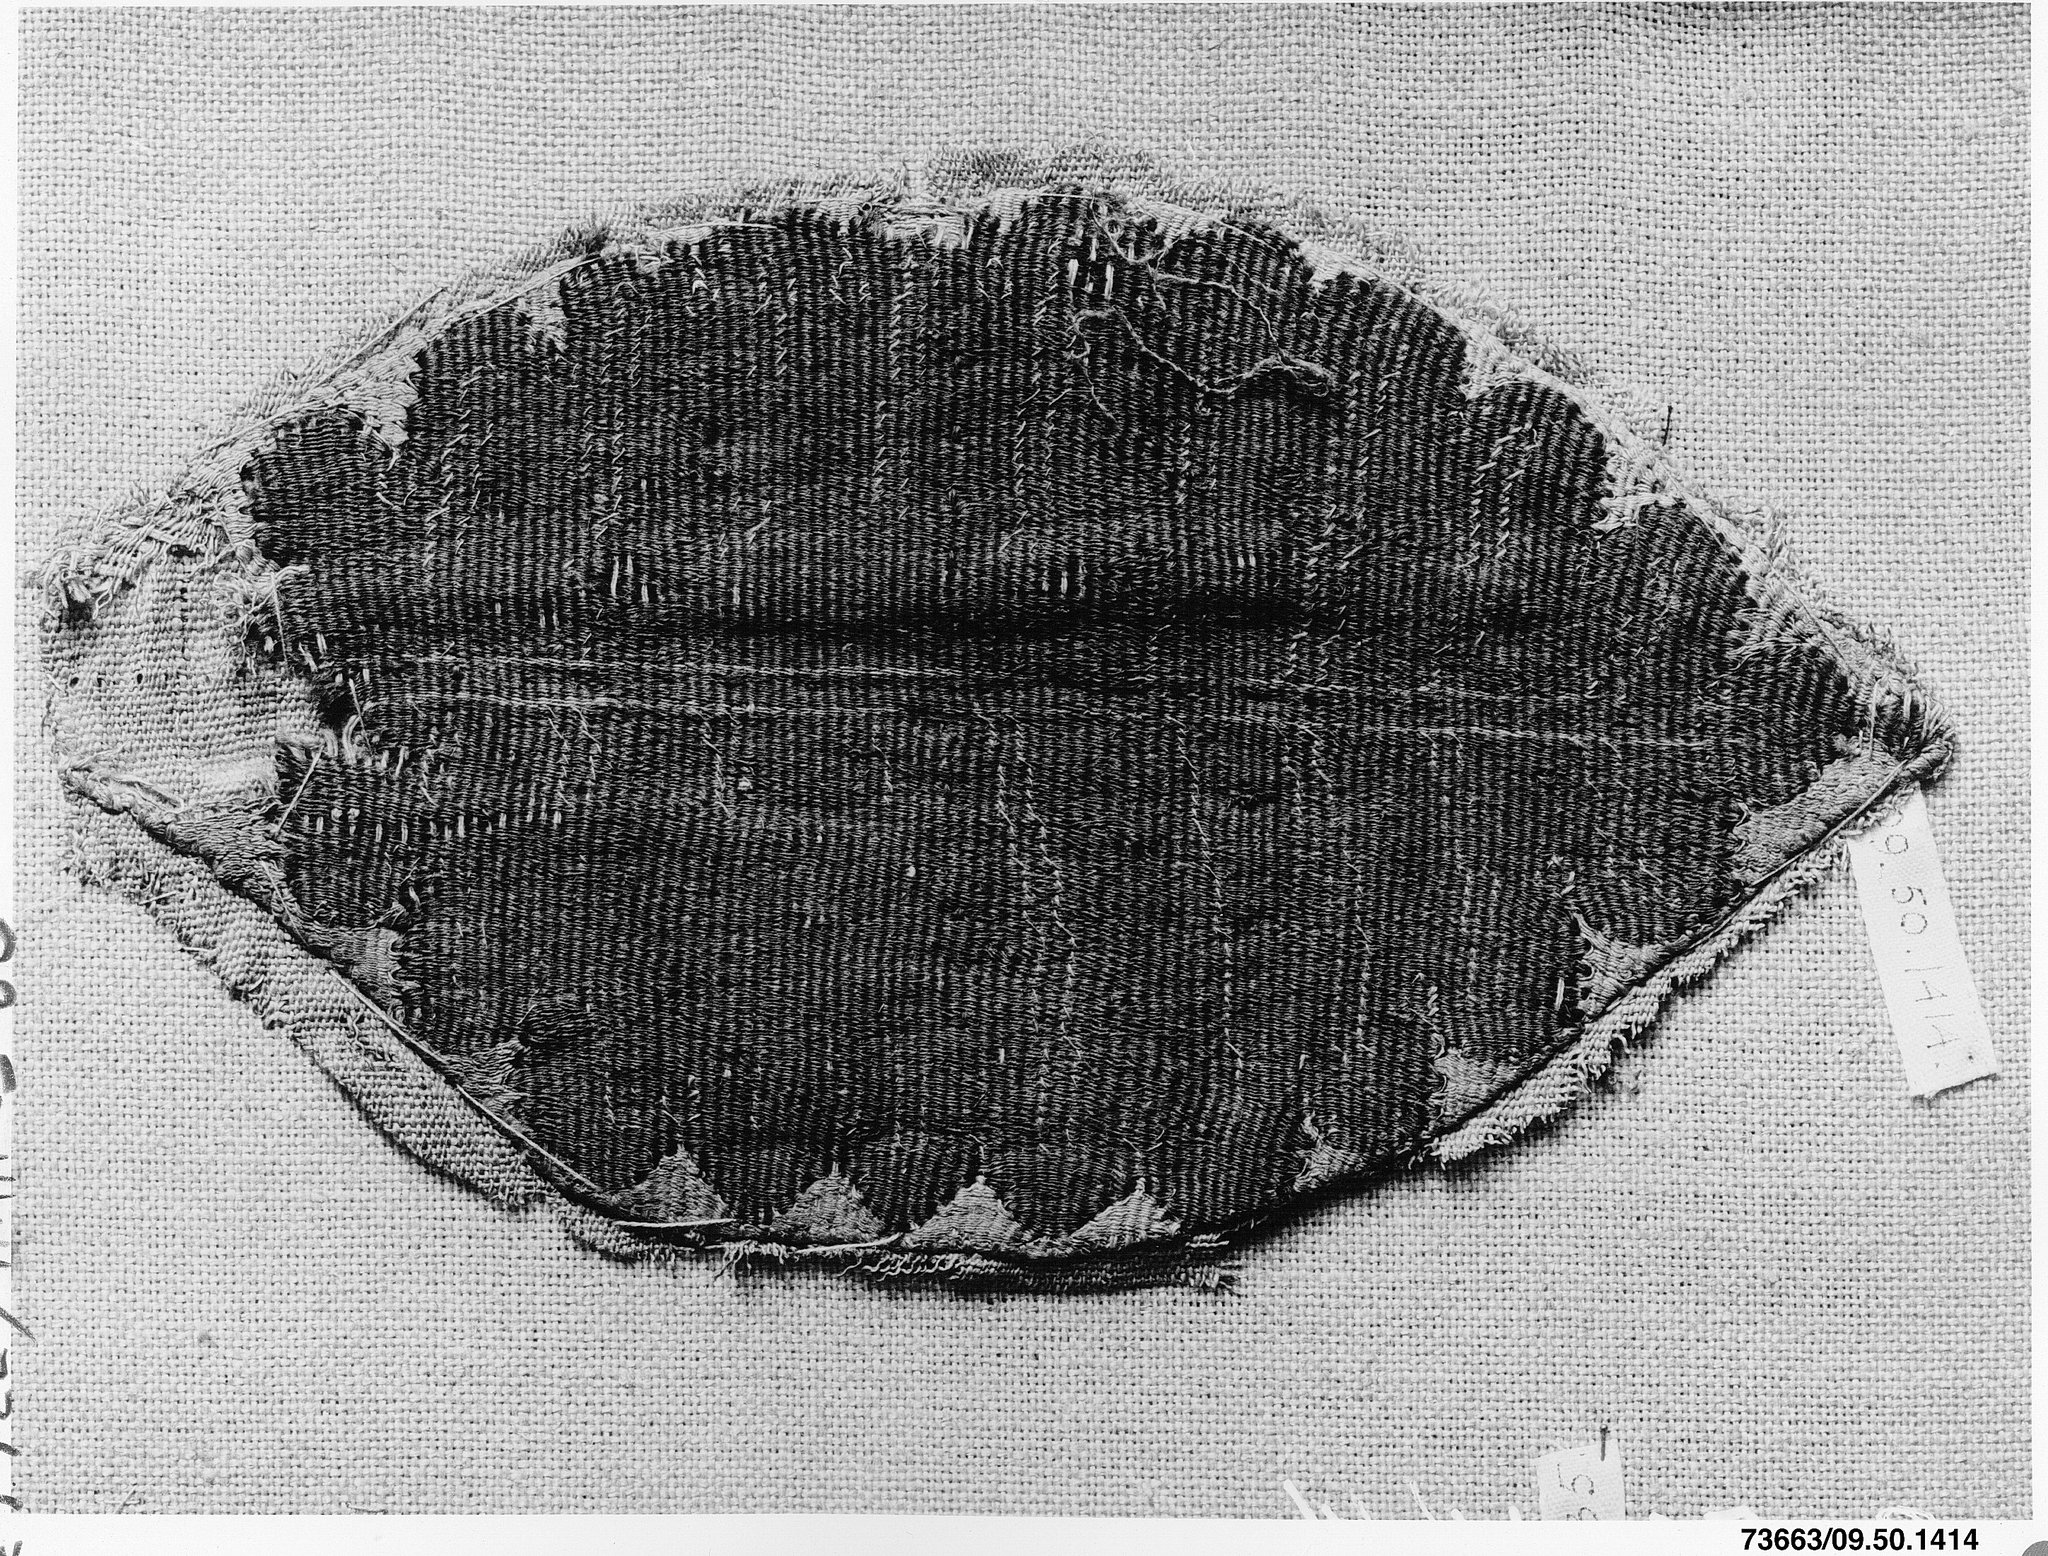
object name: textile fragment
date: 301-500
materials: linen, wool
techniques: weave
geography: egypt